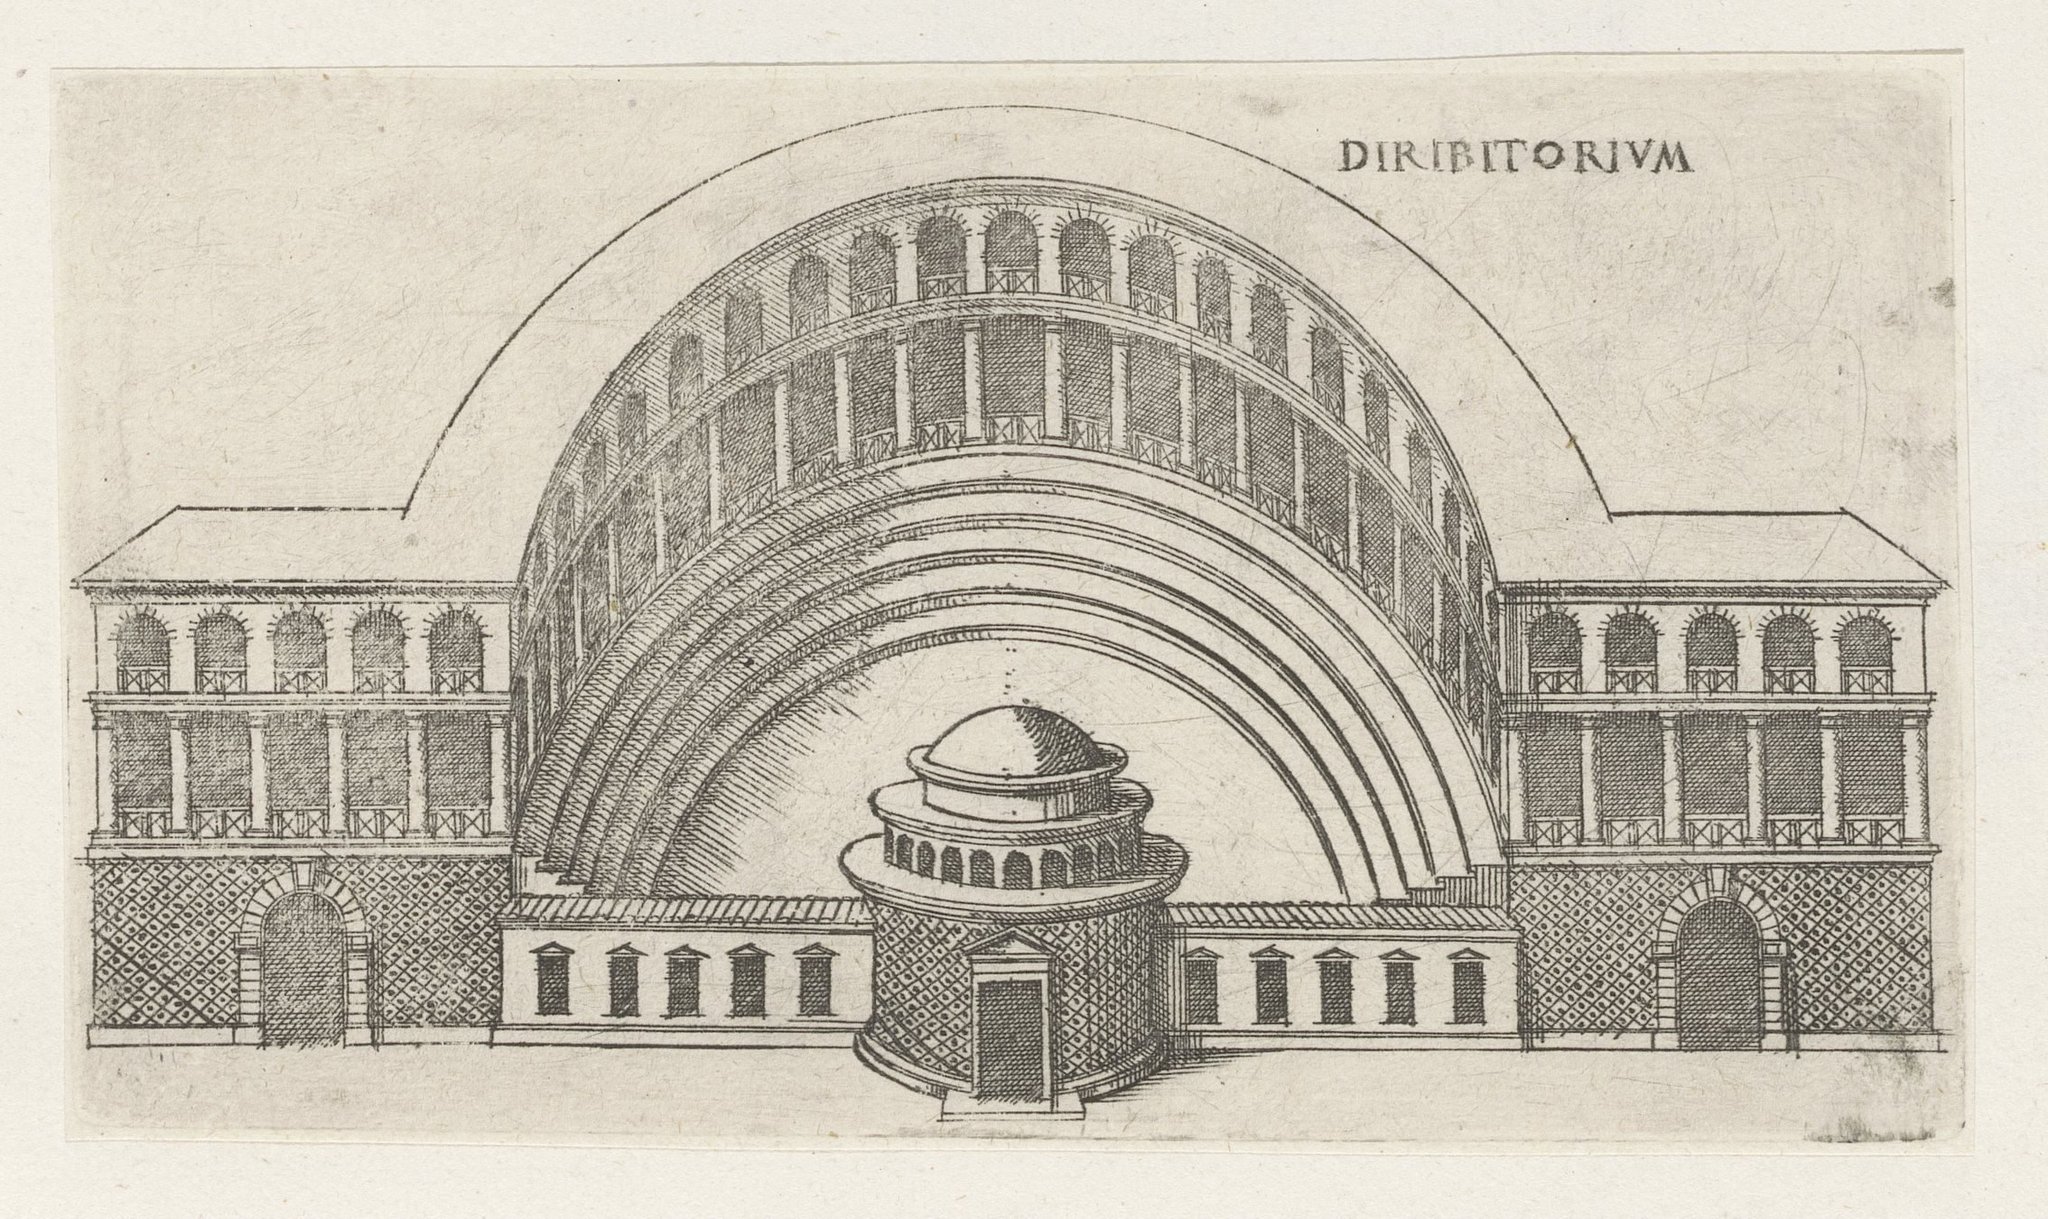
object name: album leaf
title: Diribitorium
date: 1584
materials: paper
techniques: etching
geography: france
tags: representation of real building (either existing or having existed)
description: Deze prent maakt deel uit van een serie van 98 prenten gedrukt op 48 bladen. De bladen zijn verknipt en een selectie van de losse prenten is in dit album geplakt.